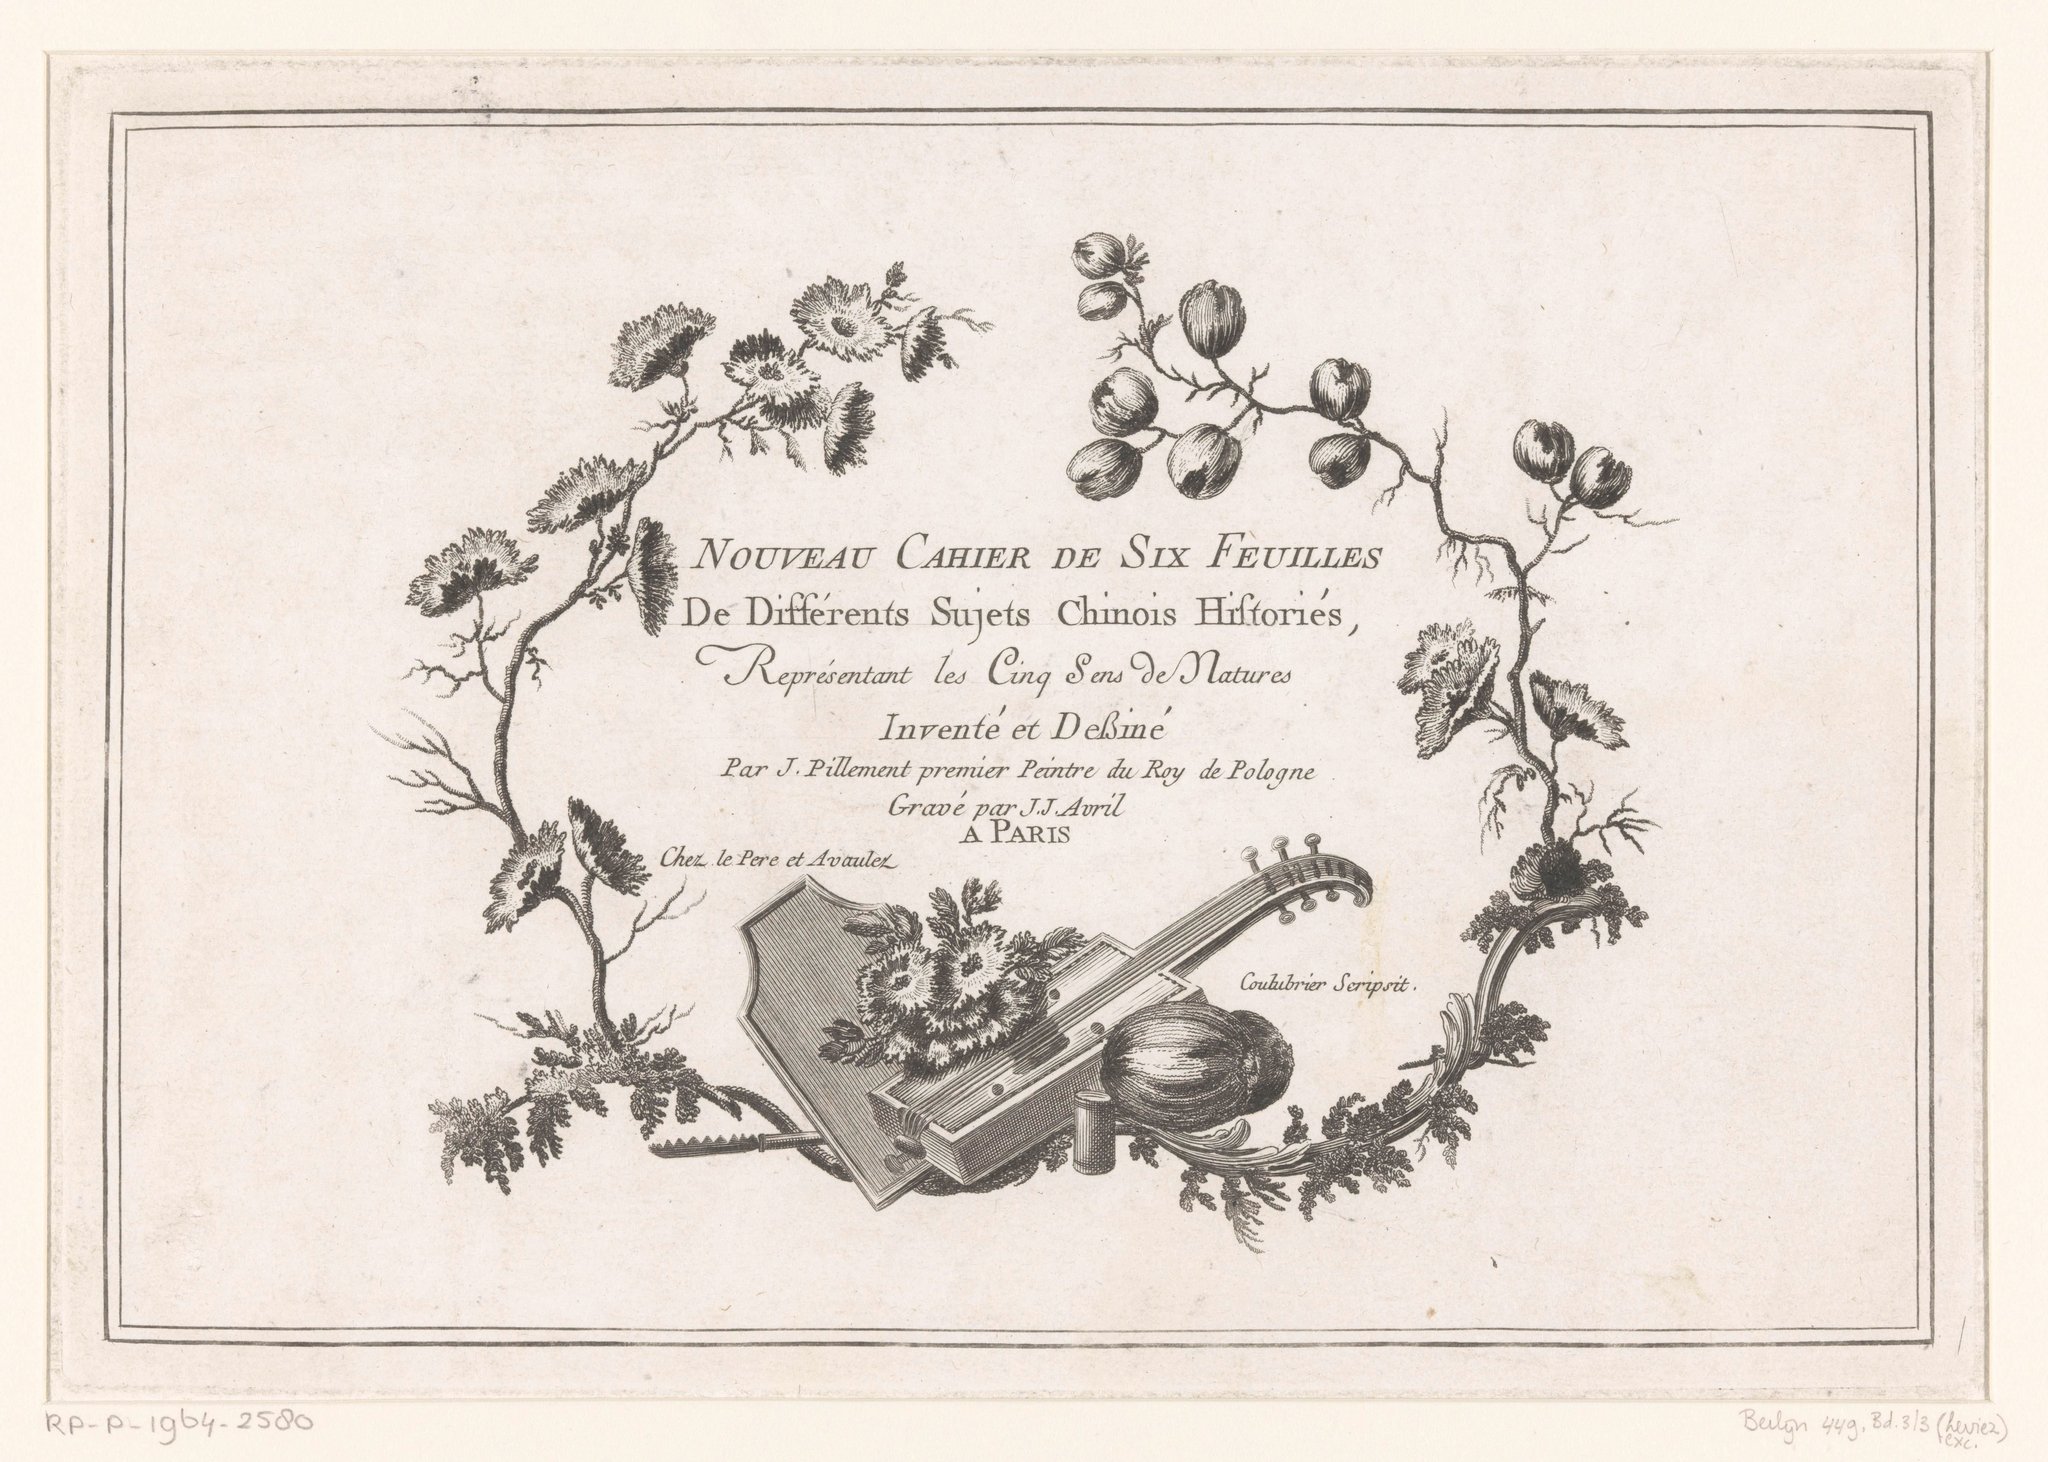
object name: titelprent, frontispice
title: Bloemenomlijsting met instrument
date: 1773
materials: paper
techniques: etching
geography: paris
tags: ornaments ~ art (+ framing decorations), string instruments (plucked)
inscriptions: collector's mark: Lugt 2228, collector's mark: Lugt 2760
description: Rondom de serietitel een omlijsting met bloemen, vruchten en een snaarinstrument.